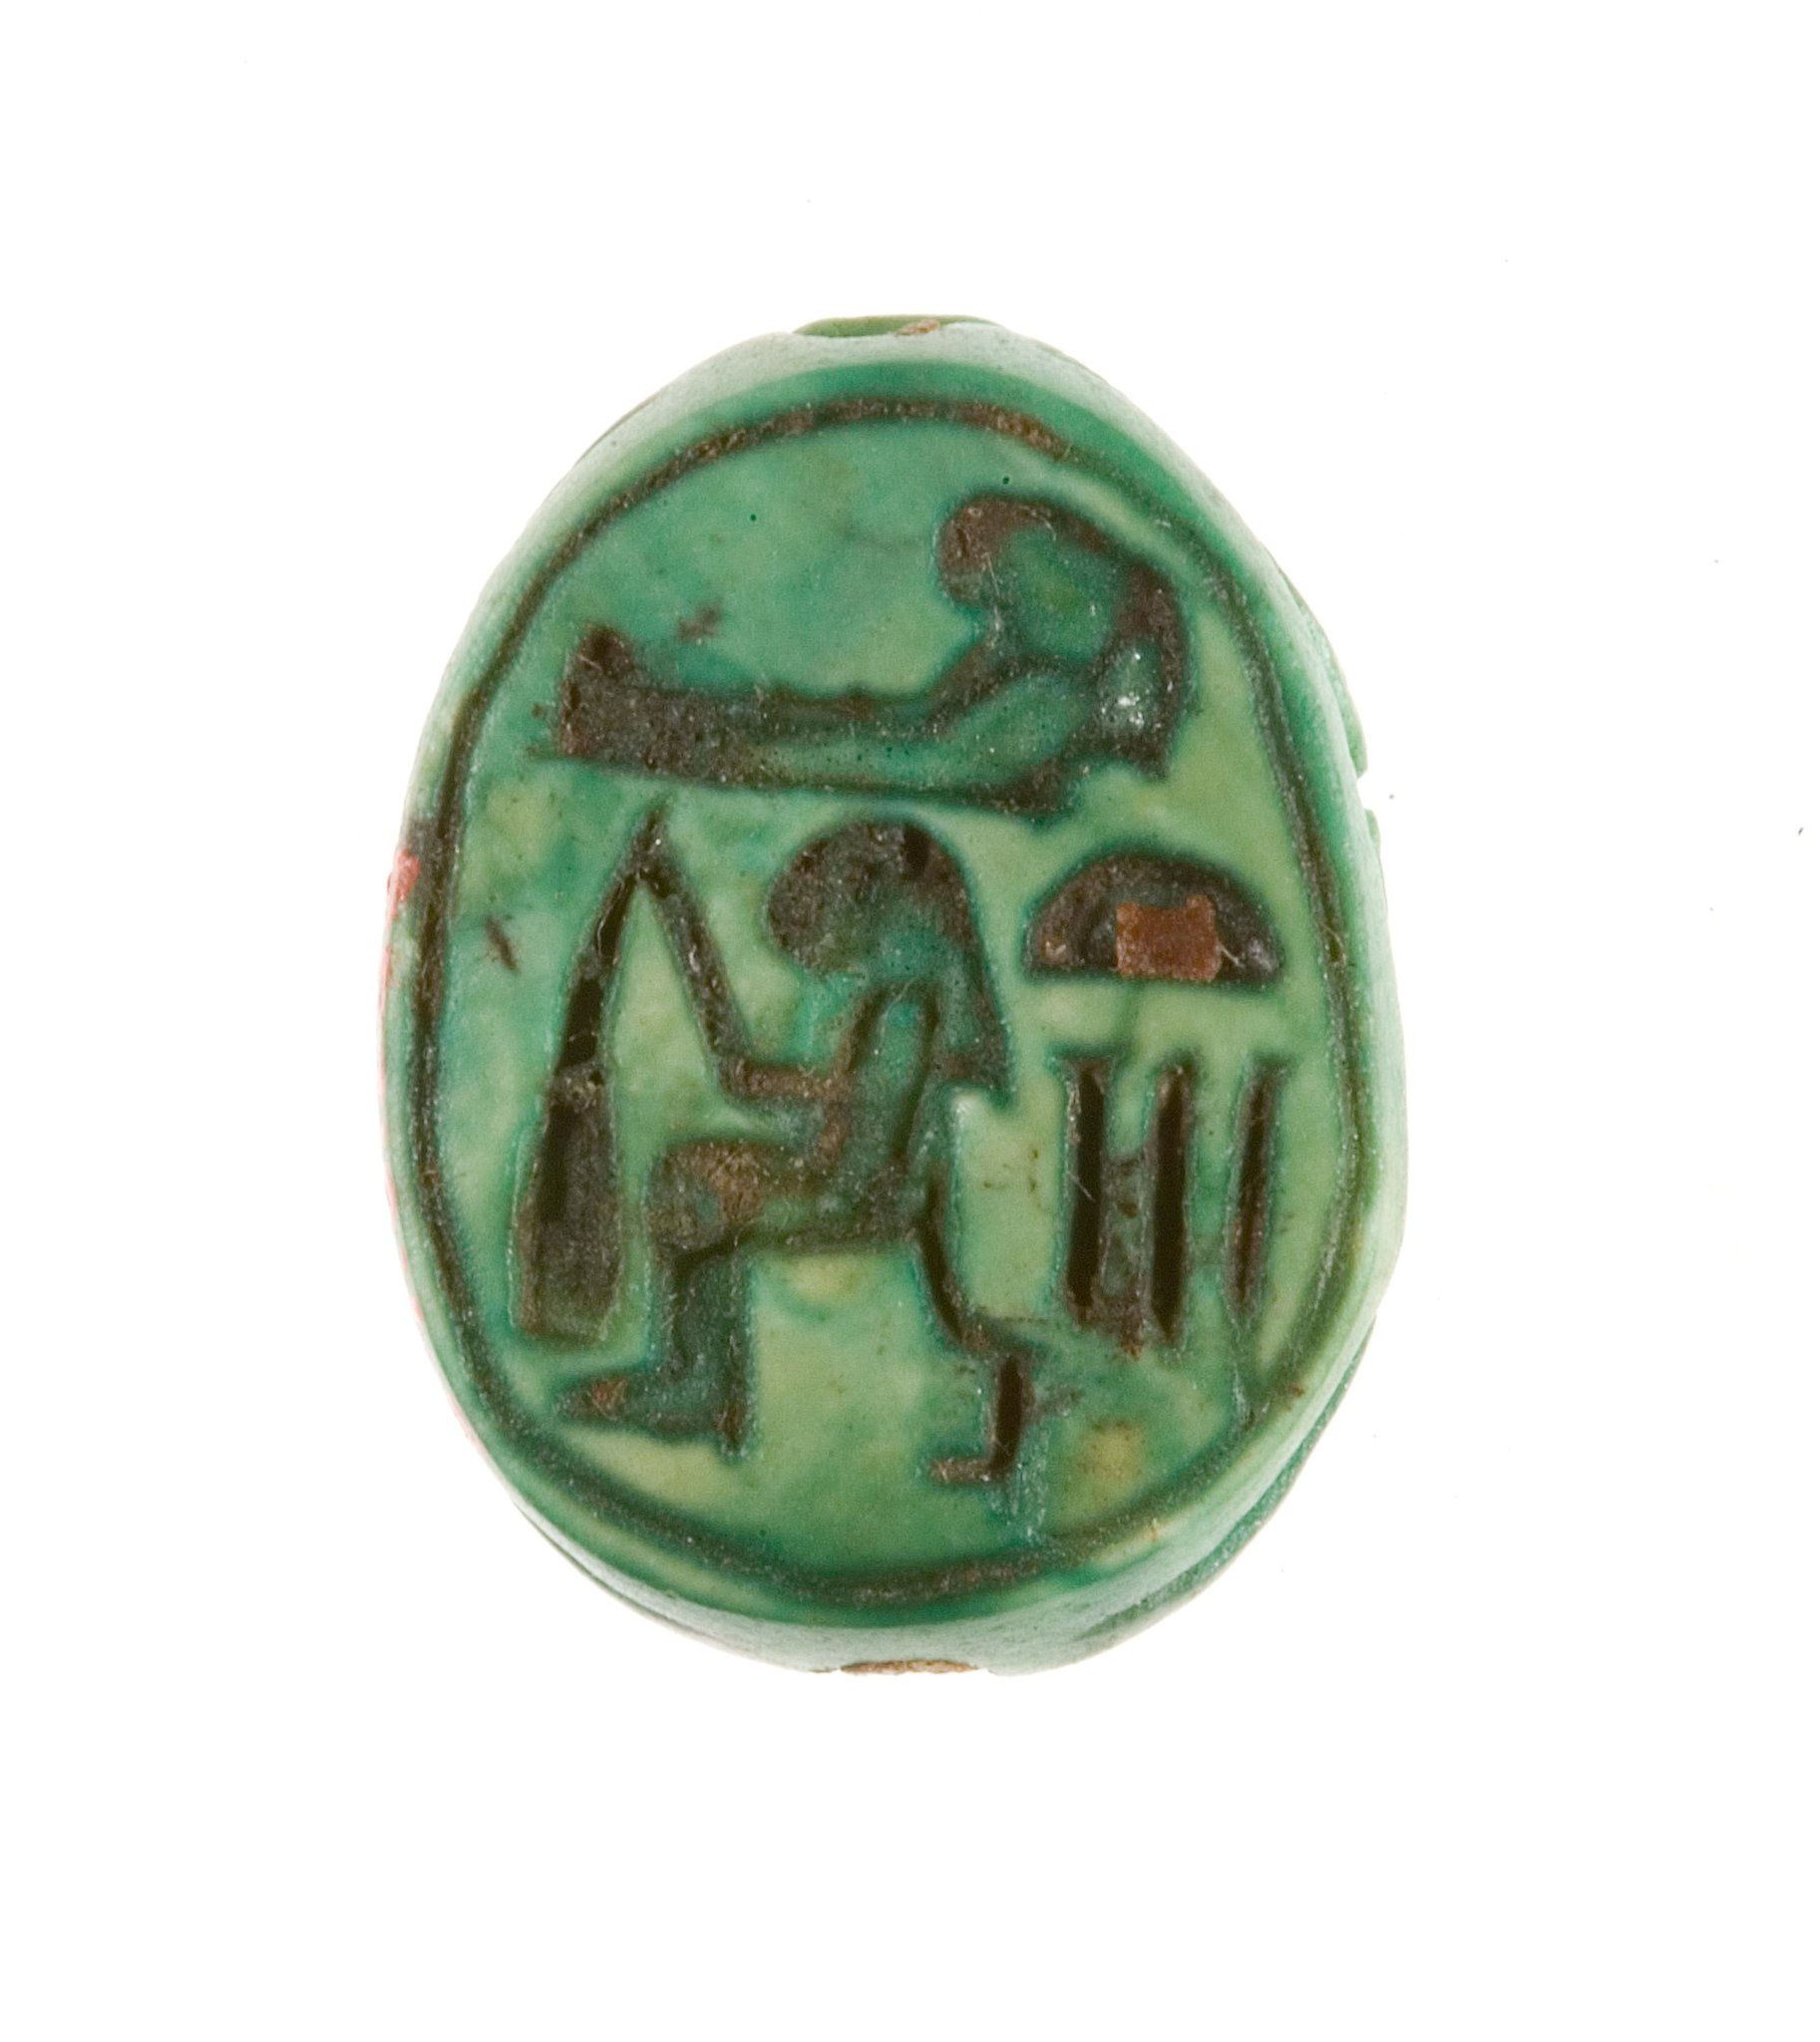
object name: scarab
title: Scarab Inscribed for Hatshepsut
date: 1479-1458 BCE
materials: stone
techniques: glazing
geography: egypt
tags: hieroglyphs,scarabs